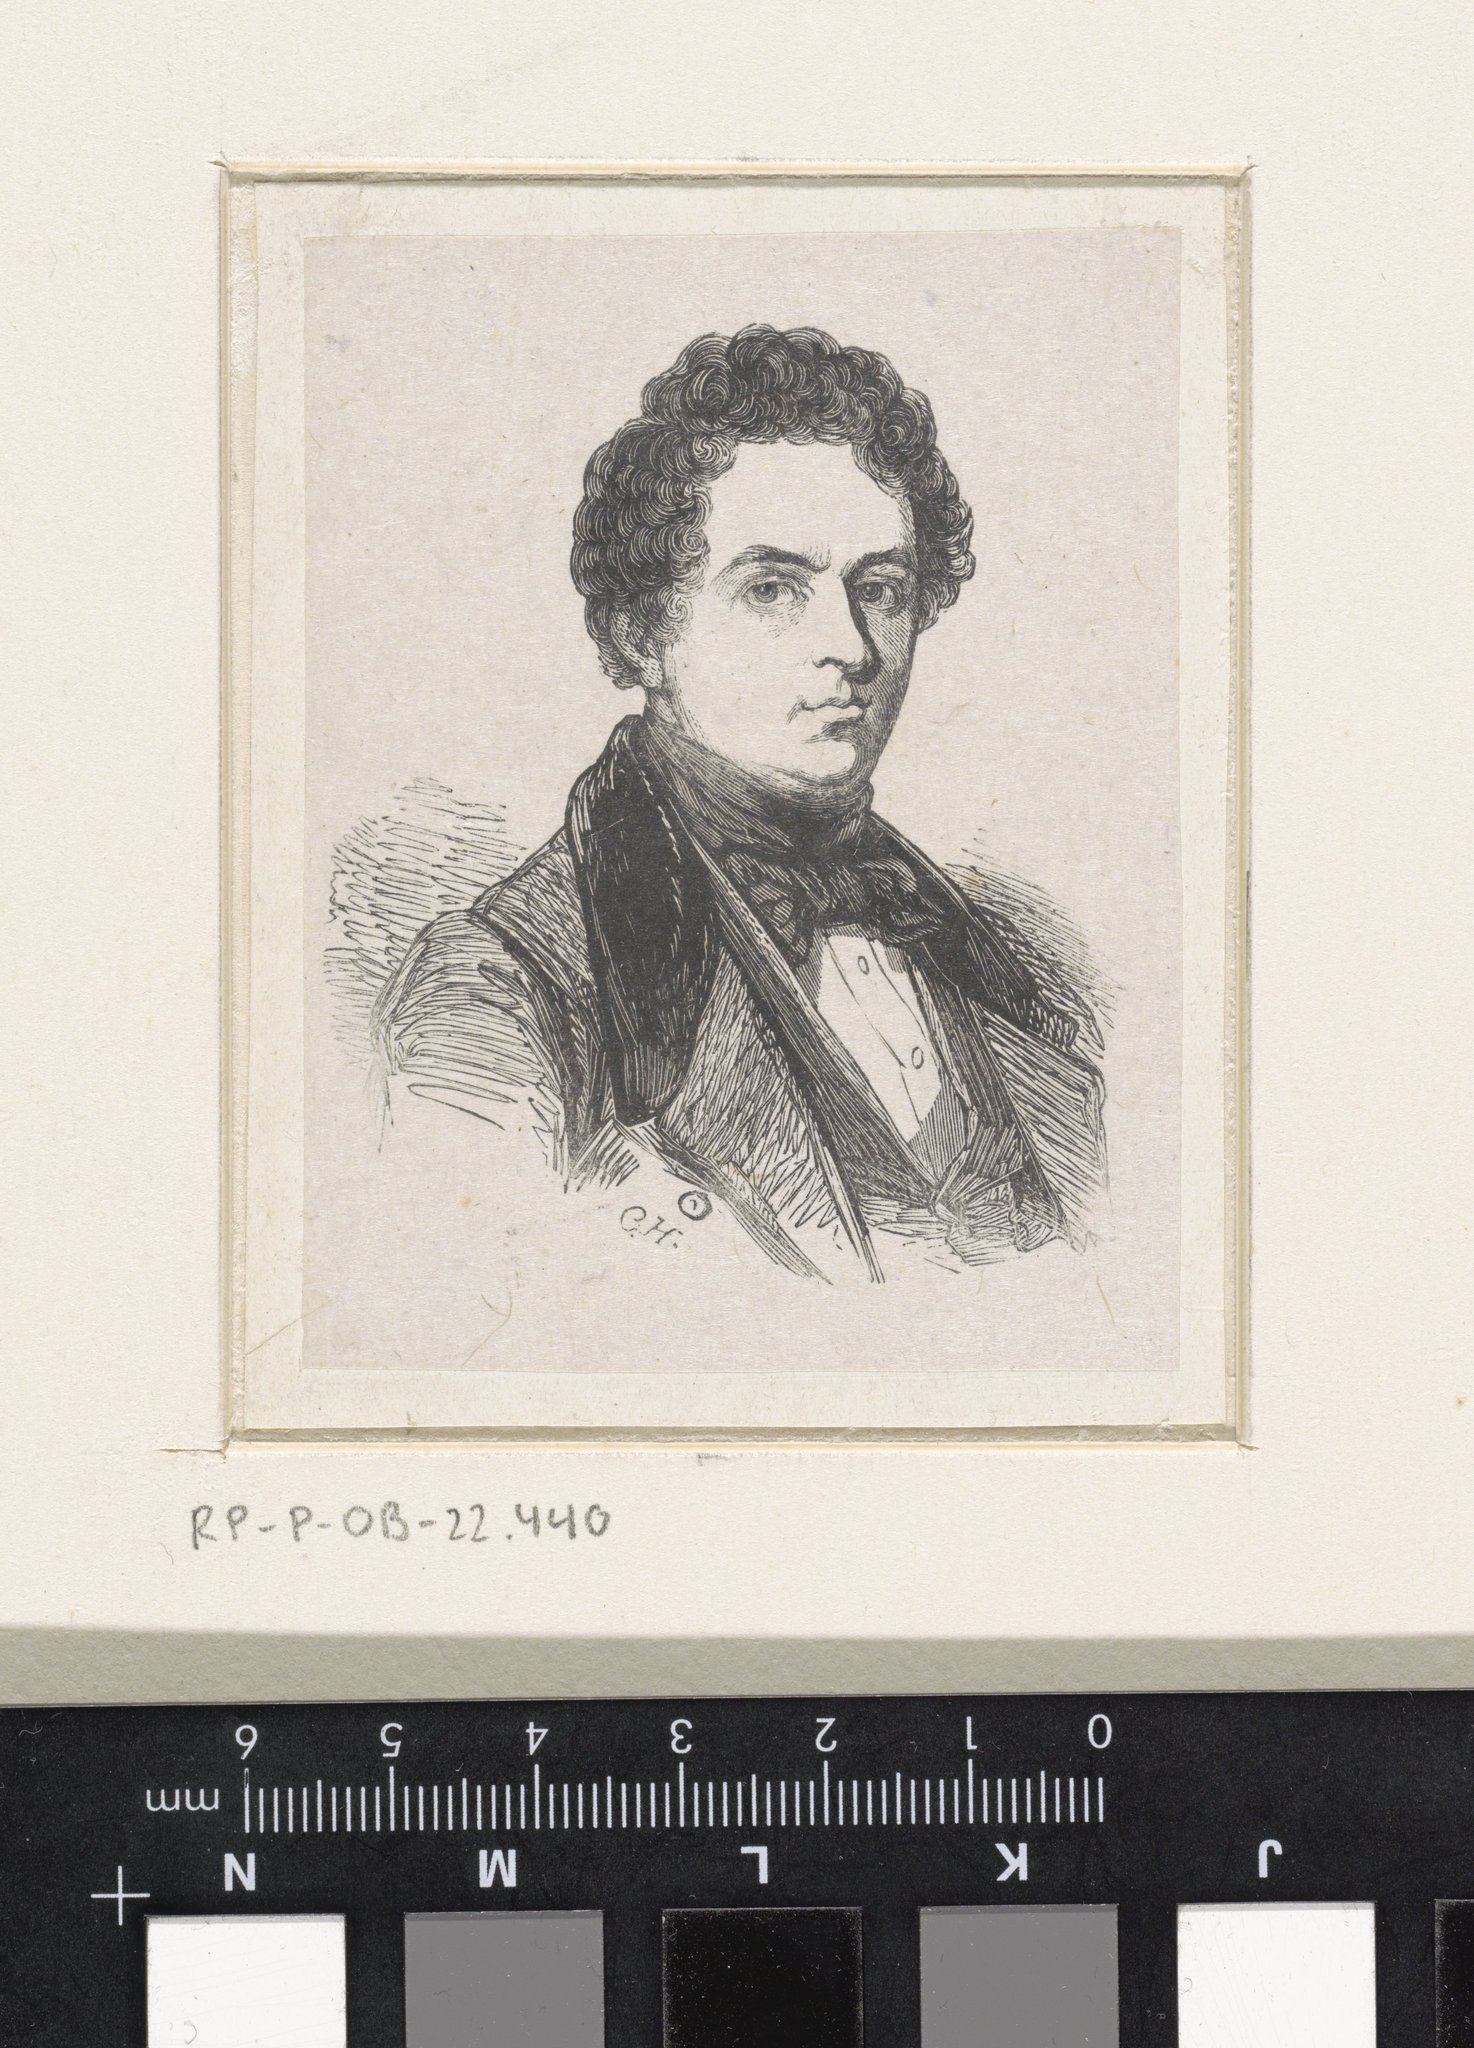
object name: print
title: Portret van Hubertus van Hove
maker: coenraad hamburger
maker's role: draughtsman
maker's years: 1809-1891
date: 1842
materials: paper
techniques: engraving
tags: hubertus van hove, historical persons, portrait, self-portrait of painter, portrait, self-portrait of artist, portrait, self-portrait of draughtsman